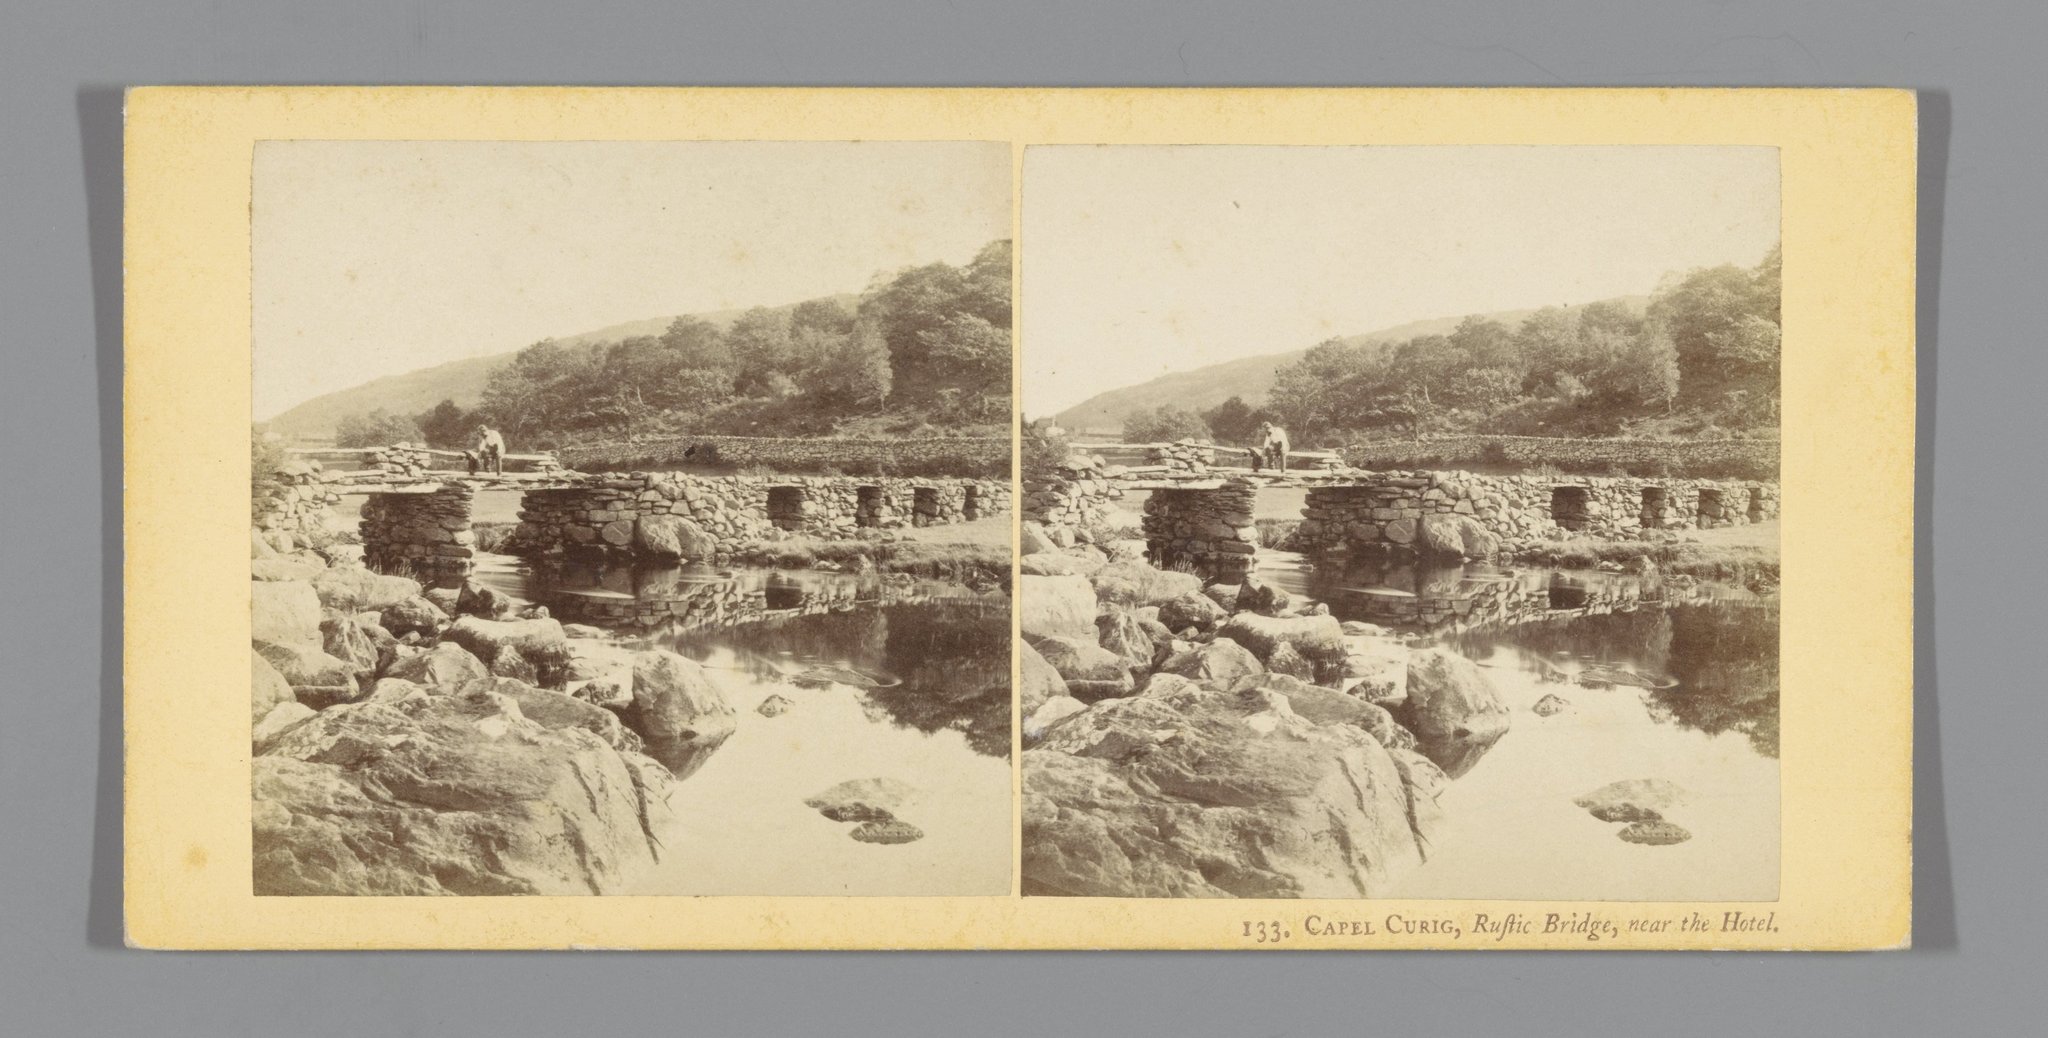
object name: stereograph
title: Capel Curig, Rustic Bridge, near the Hotel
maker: Anonymous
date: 1850-1880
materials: cardboard, photographic support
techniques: albumen print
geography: capel curig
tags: bridge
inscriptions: number: ‘133.’